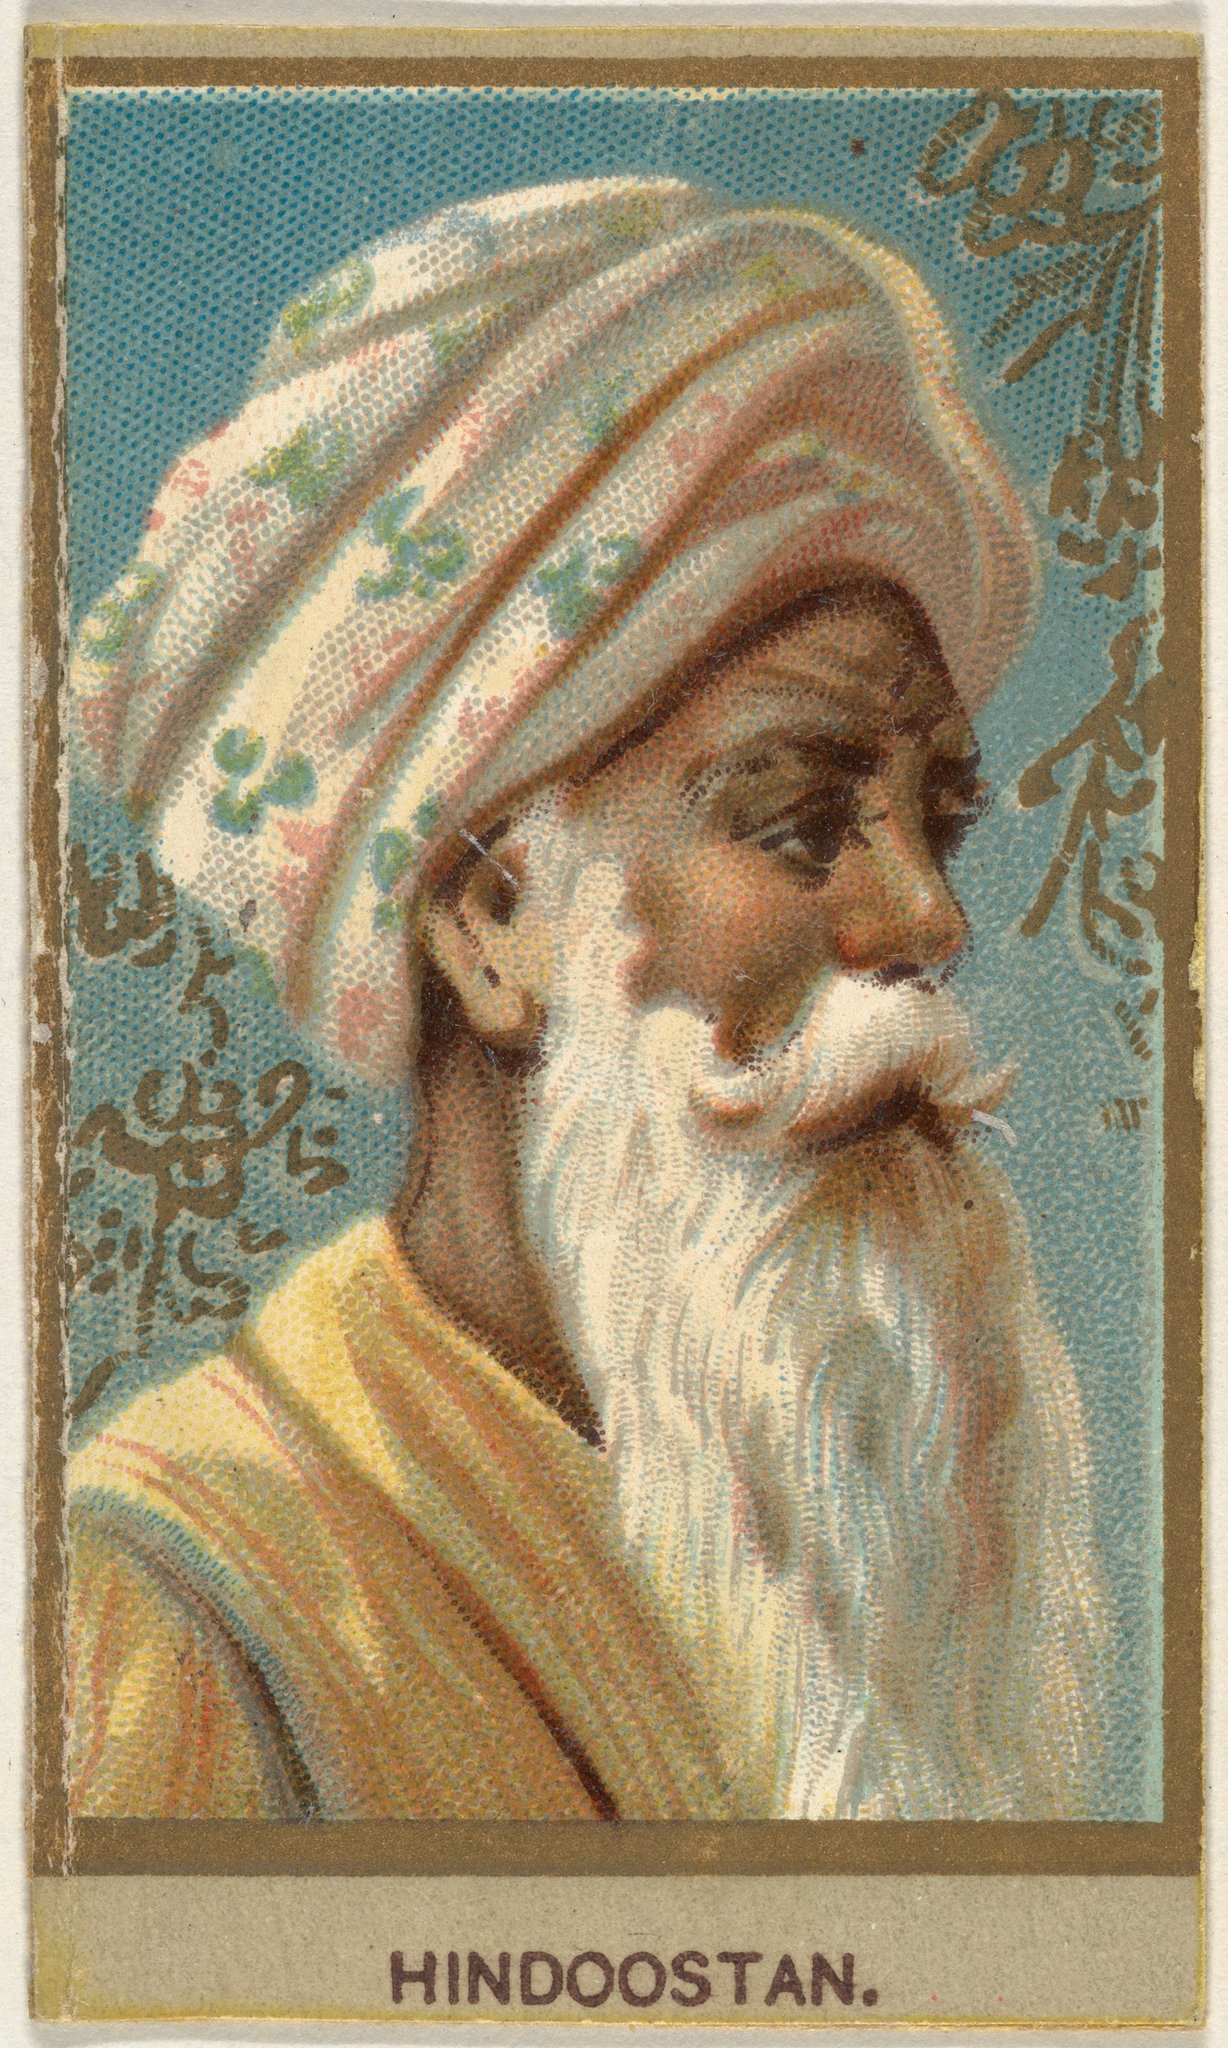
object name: print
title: Hindoostan, from the Races of Mankind series (T181) issued by Abdul Cigarettes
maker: abdul cigarettes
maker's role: publisher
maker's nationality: american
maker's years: 1881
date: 1881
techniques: color lithograph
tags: men,profiles